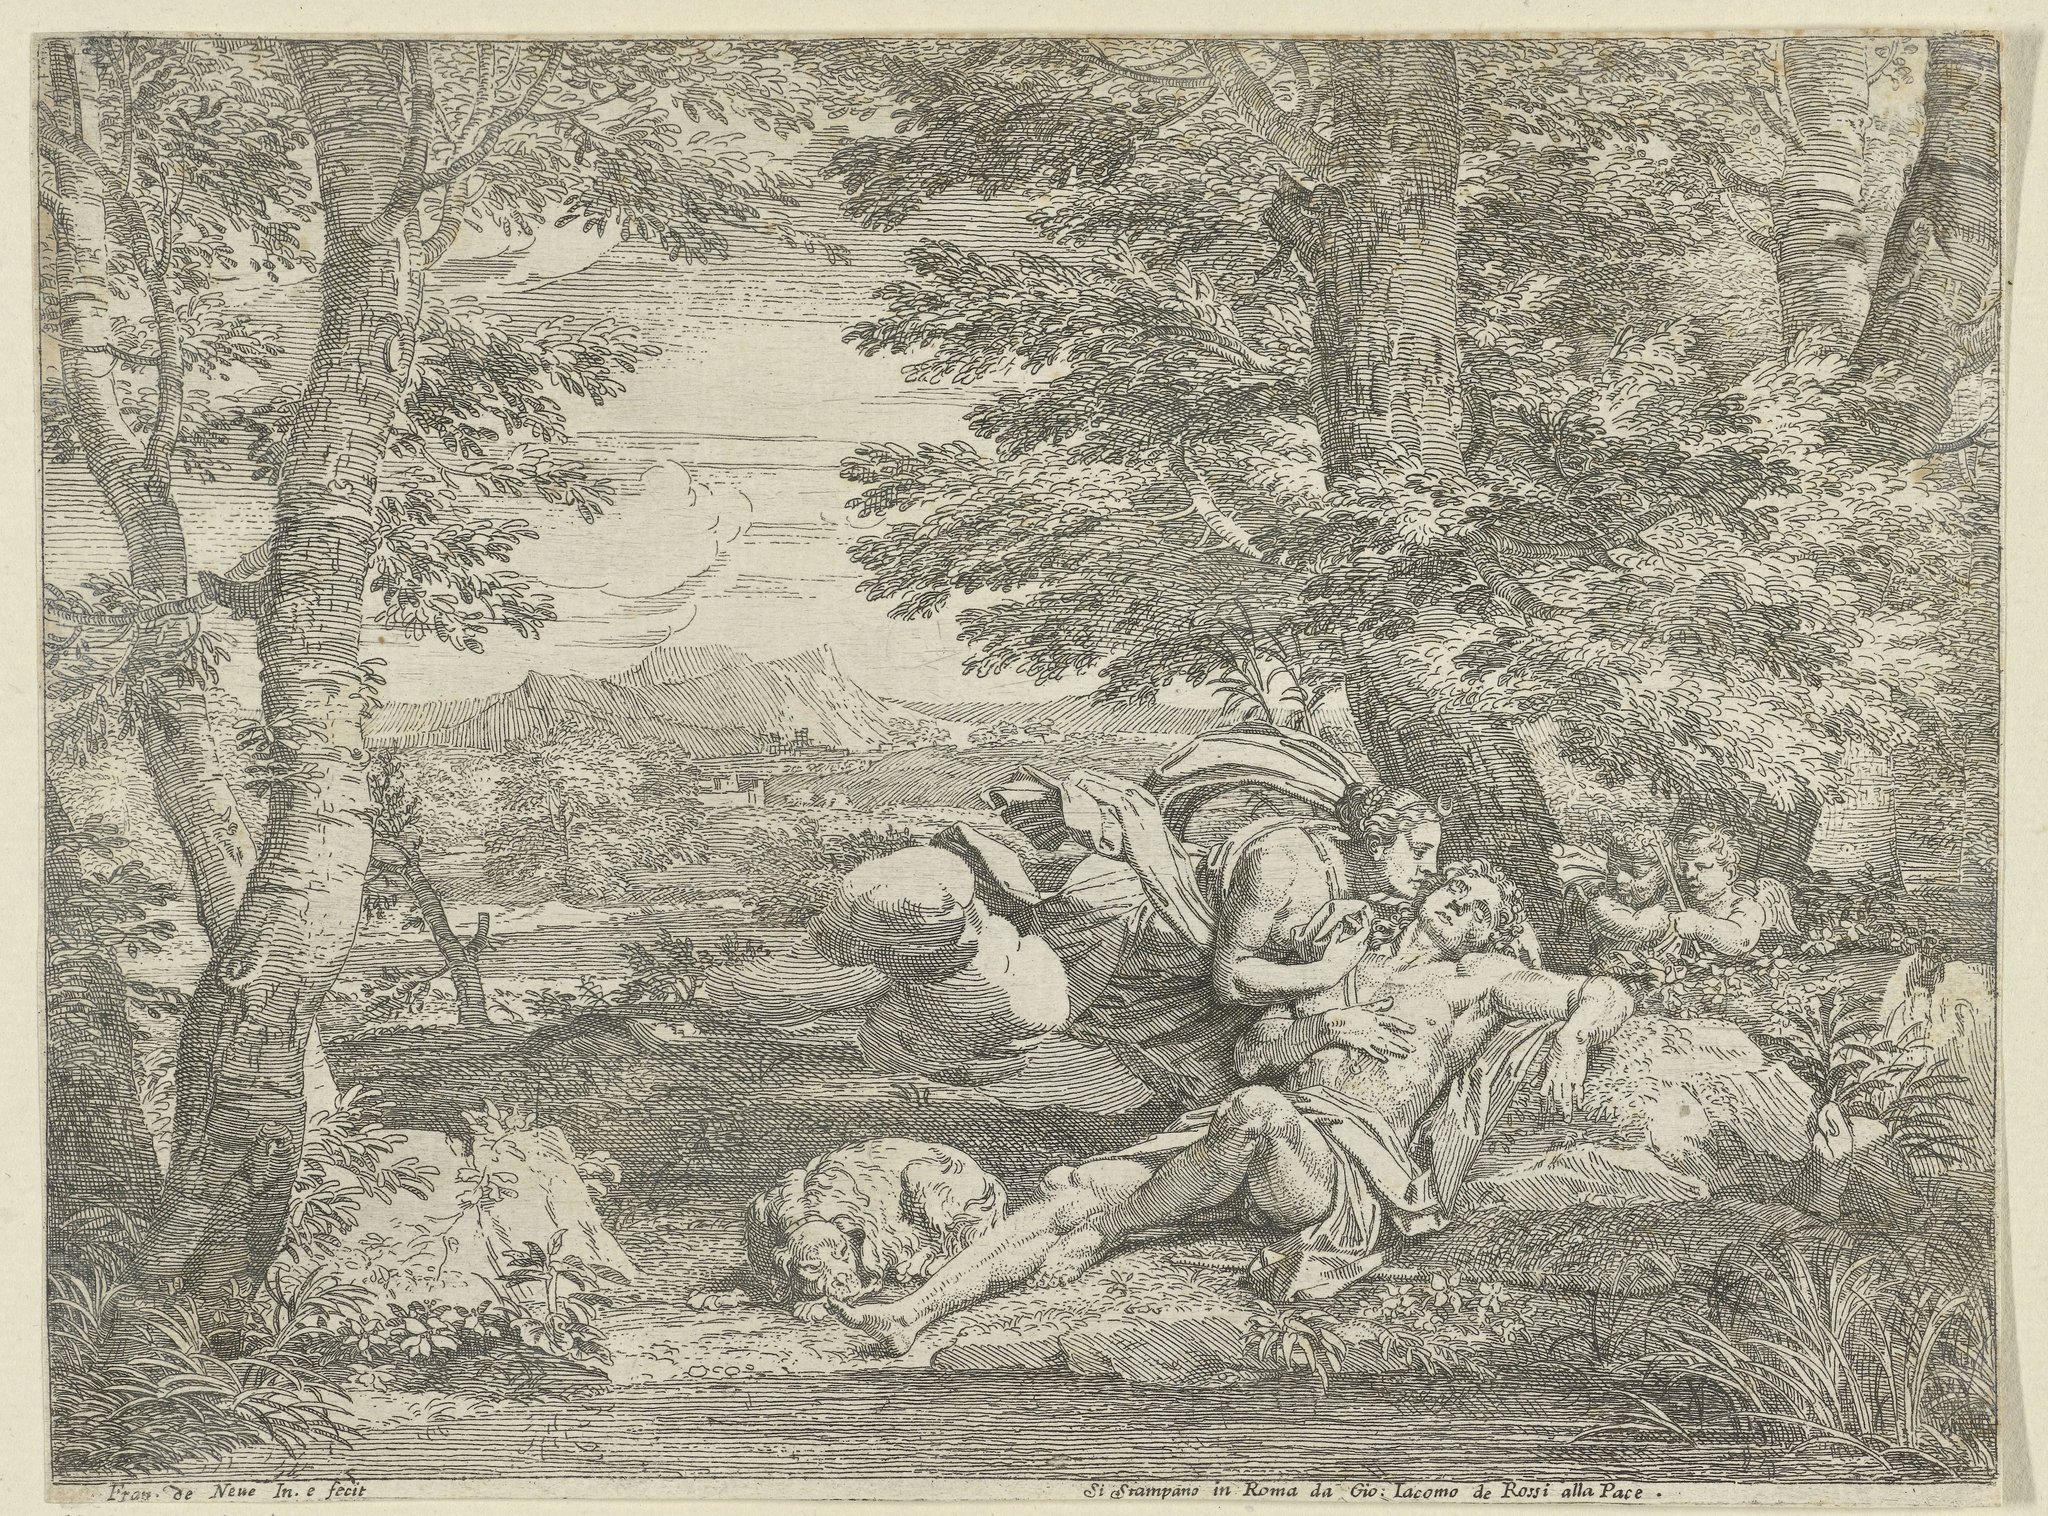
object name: print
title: Diana en Endymion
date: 1660-1666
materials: paper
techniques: etching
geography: rome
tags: diana (luna) visiting the sleeping endymion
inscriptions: collector's mark: Lugt 240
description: Diana bezoekt de eeuwig slapende schone jongeling Endymion. Het tafereel wordt gadegeslagen door twee putti. Aan de voeten van Endymion waakt een hond.